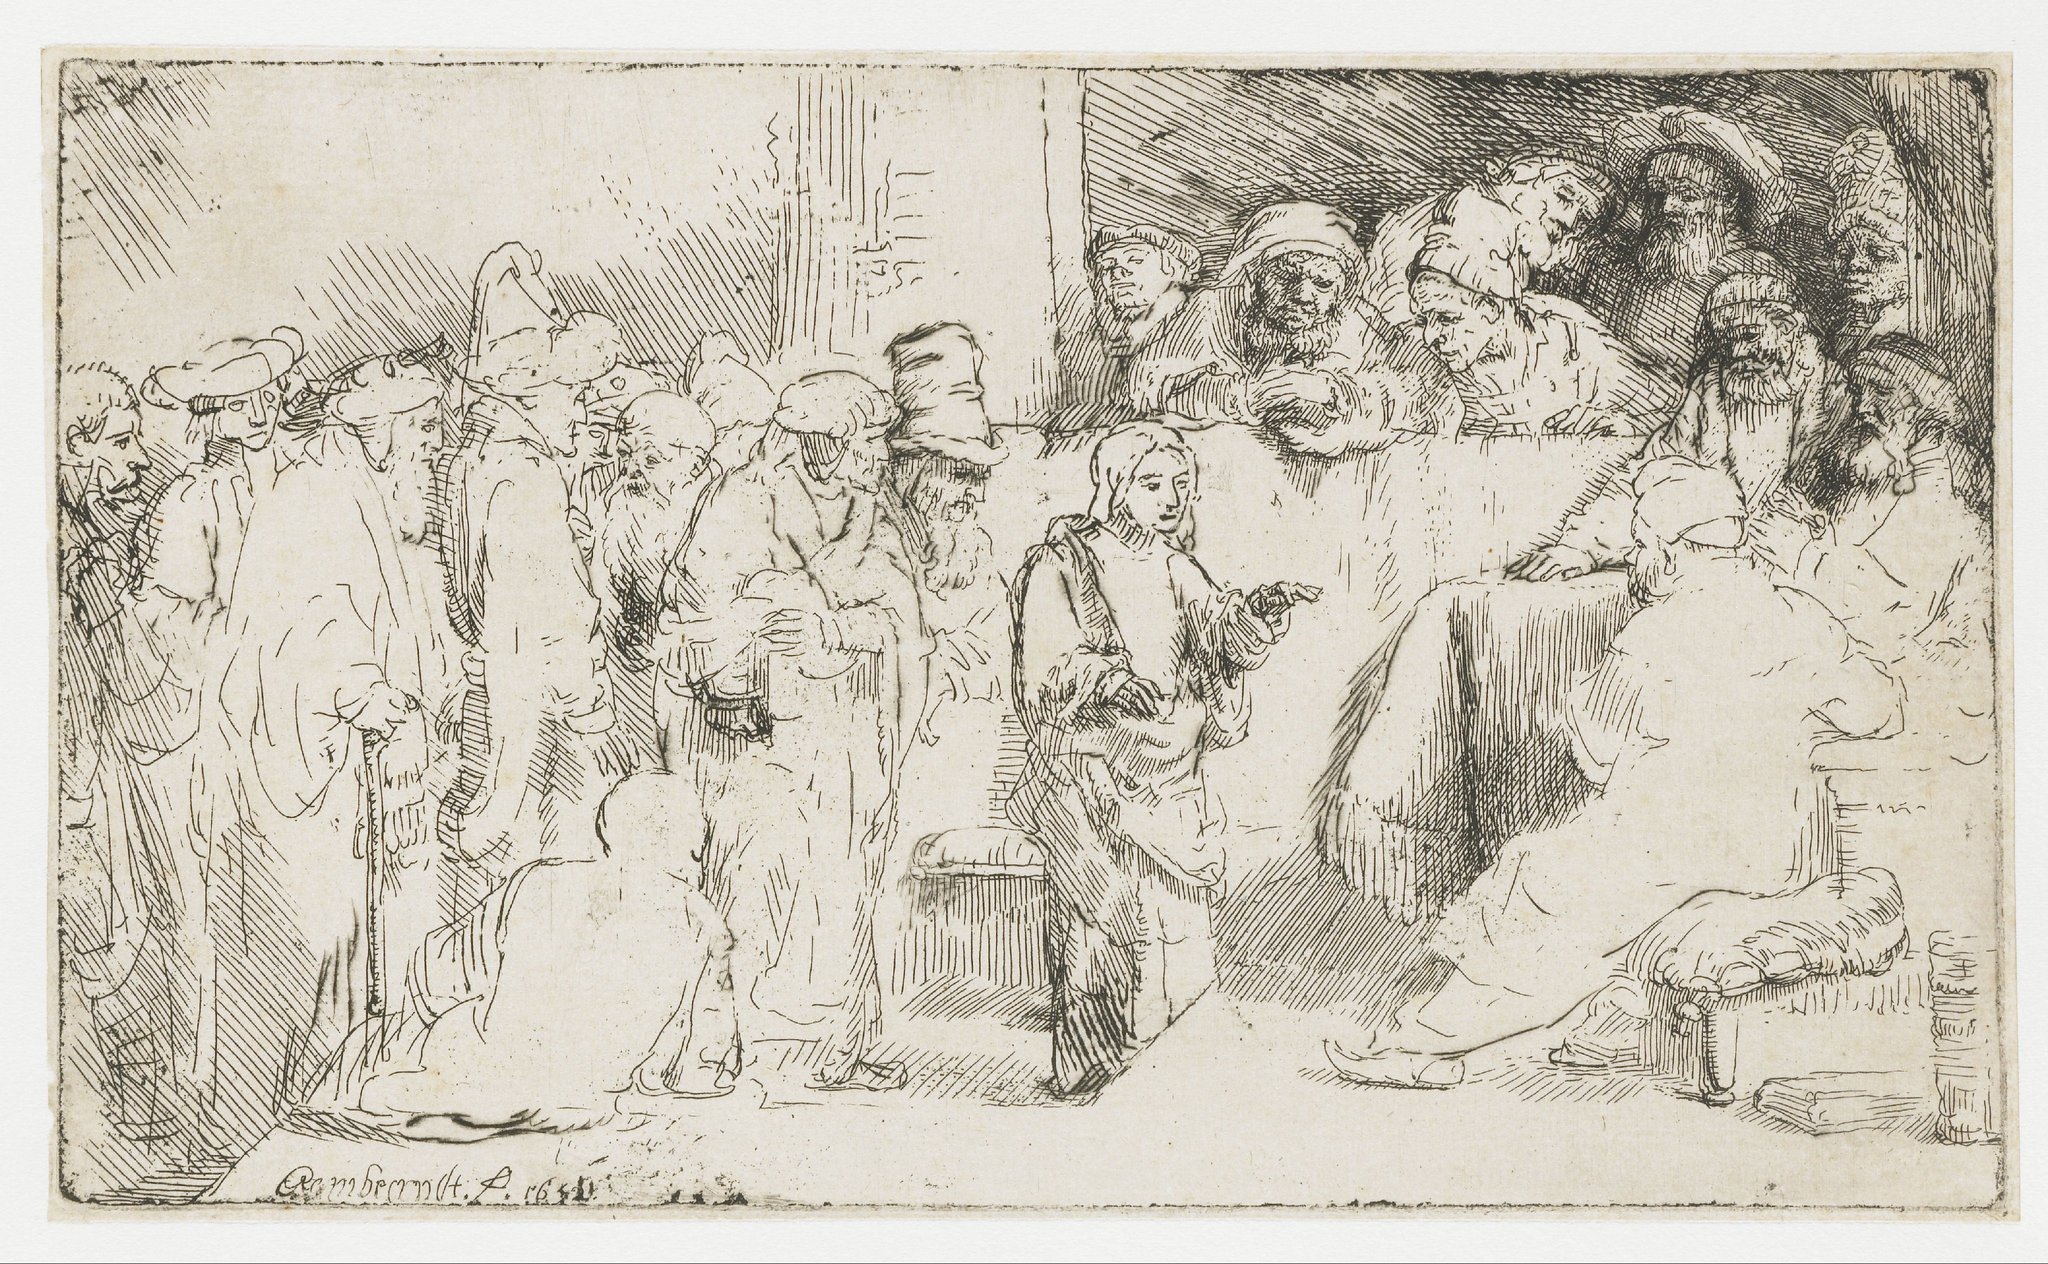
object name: print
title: Christ disputing with the Doctors: a sketch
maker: rembrandt van rijn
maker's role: draughtsman, painter, print maker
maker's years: 1606-1669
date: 1652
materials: paper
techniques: drypoint, etching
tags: christ explaining his doctrine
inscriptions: collector's mark: Lugt 2228, inscription: ‘C. 11945’, signature and date: ‘Rembrandt.f.1654’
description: The theme of Christ and the doctors requires the men visibly to express their astonishment at the unexpected wisdom of a 12-year-old boy. Perhaps this is what attracted Rembrandt to the subject: in any event, he depicted it repeatedly. It is quite conceivable that he wished to work out this hardly completed composition further. However, nothing came of it.